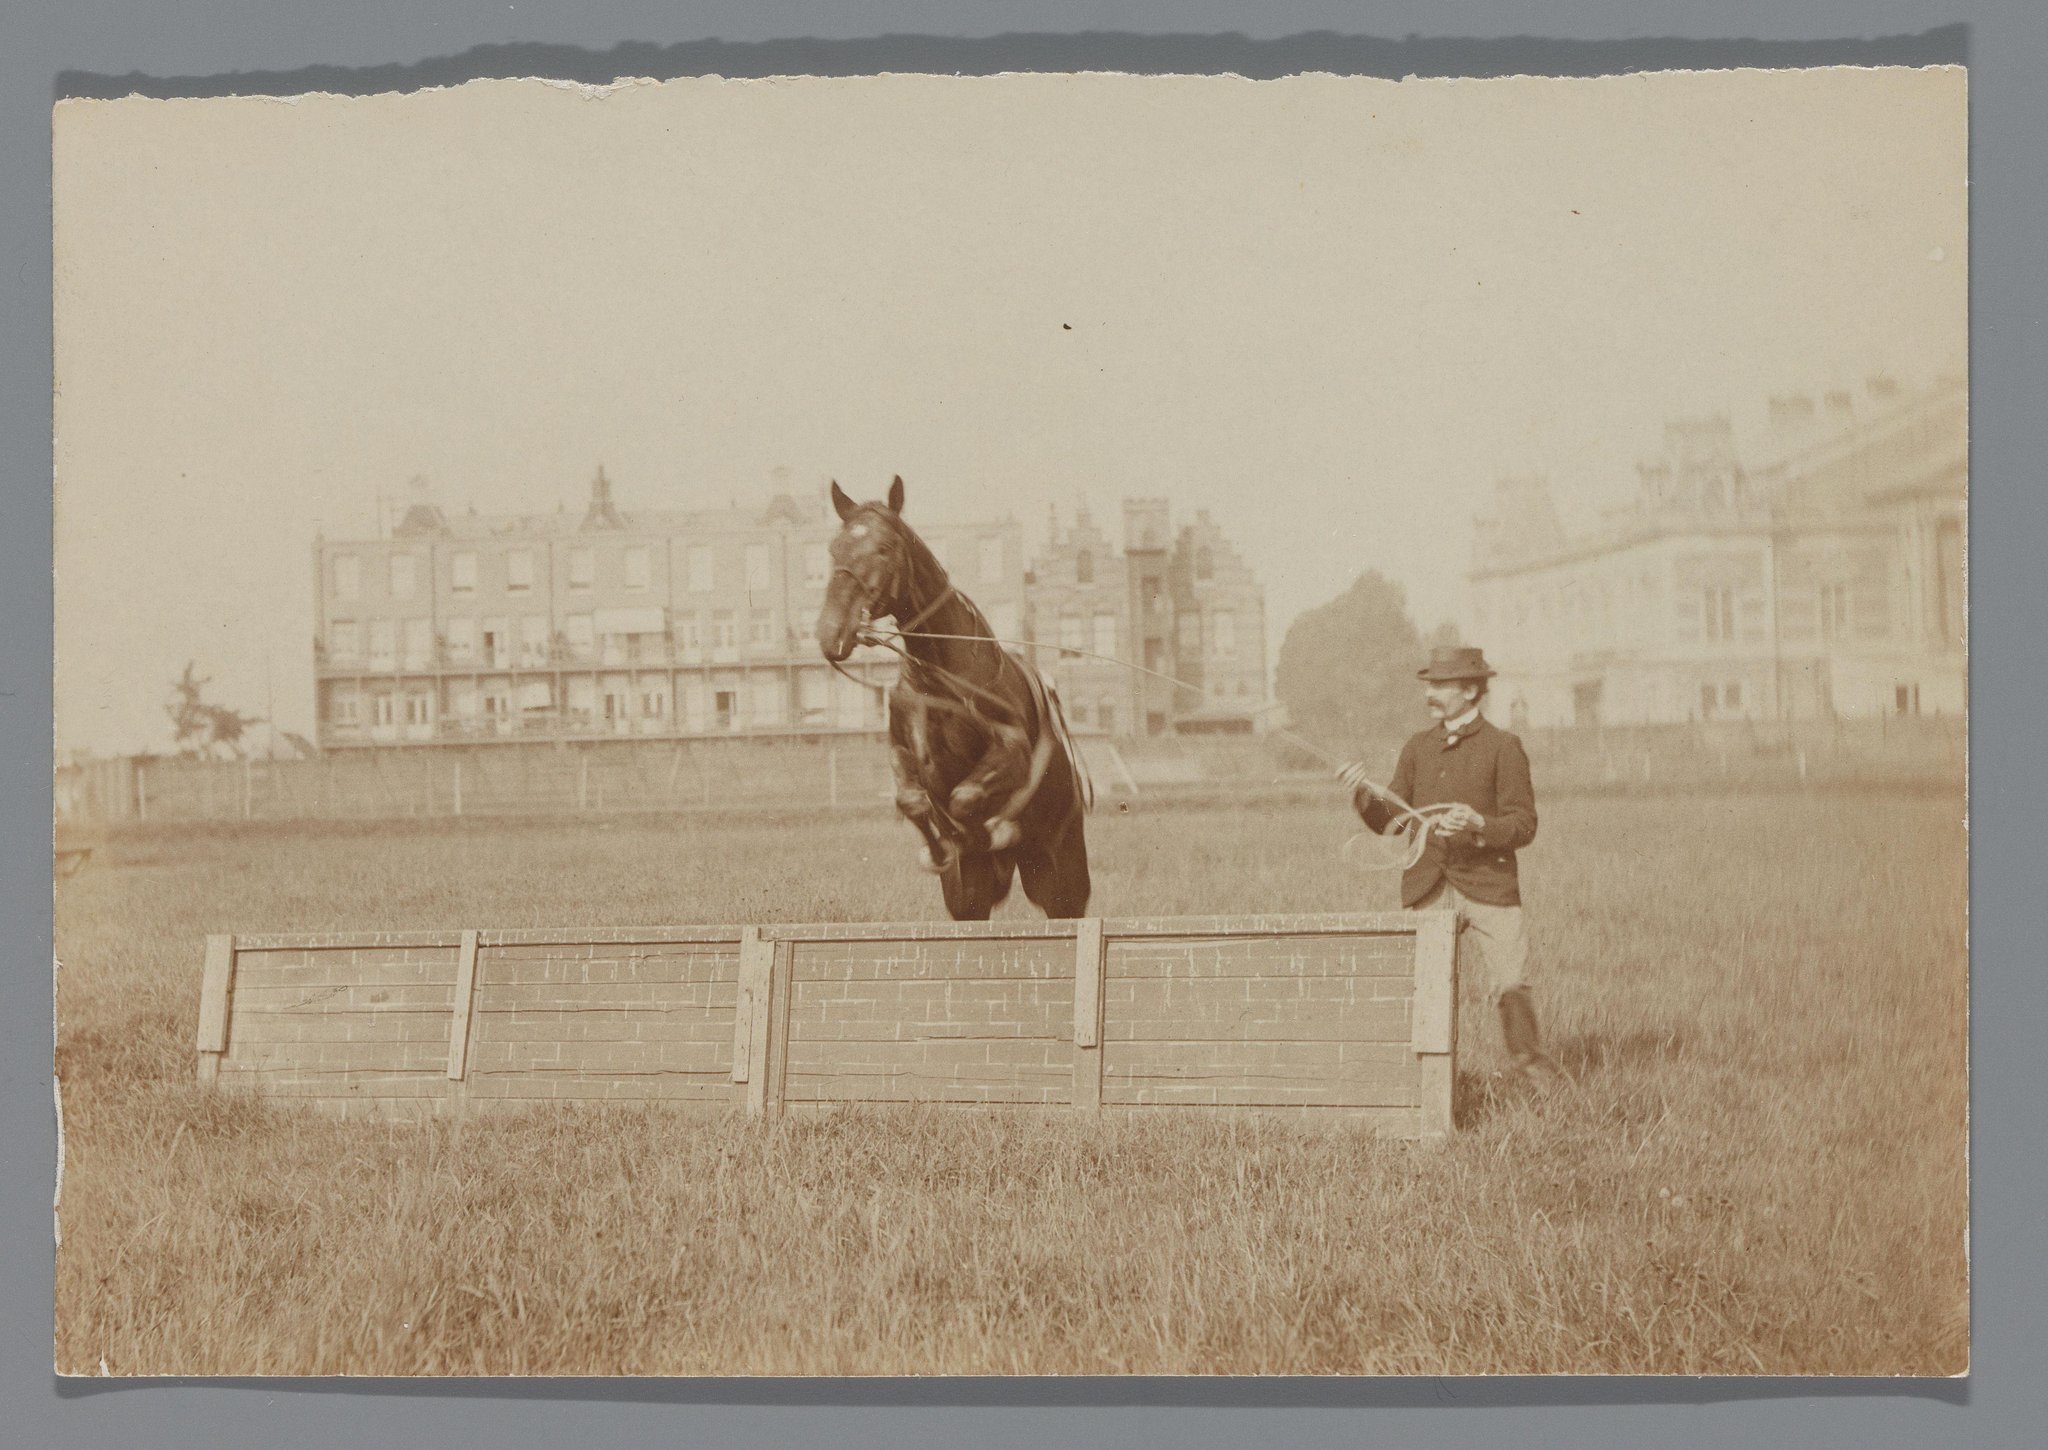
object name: photograph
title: A Man Riding the Photographer’s Horse Bobbie Taking an Obstacle on the Terrain behind the Rijksmuseum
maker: hendrik herman van den berg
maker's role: amateurfotograaf, jurist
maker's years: 1875-1944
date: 1890-1900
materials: photographic support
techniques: collodion silver print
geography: amsterdam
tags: amsterdam